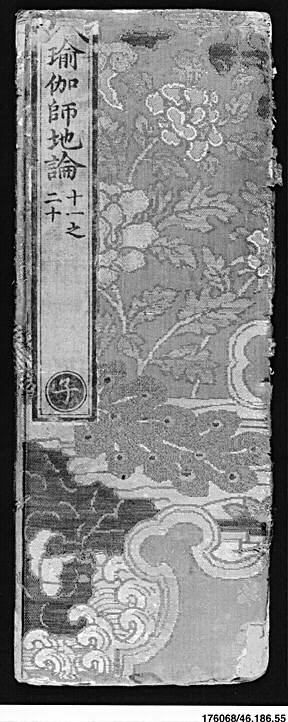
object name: sutra cover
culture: chinese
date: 1601-1700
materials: metal thread, silk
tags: flowers